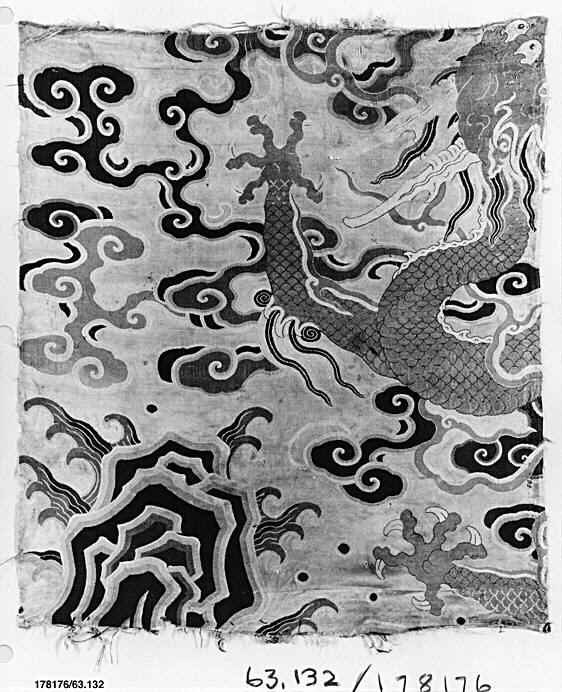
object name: piece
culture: chinese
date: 1701-1733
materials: metal thread, silk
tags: dragons